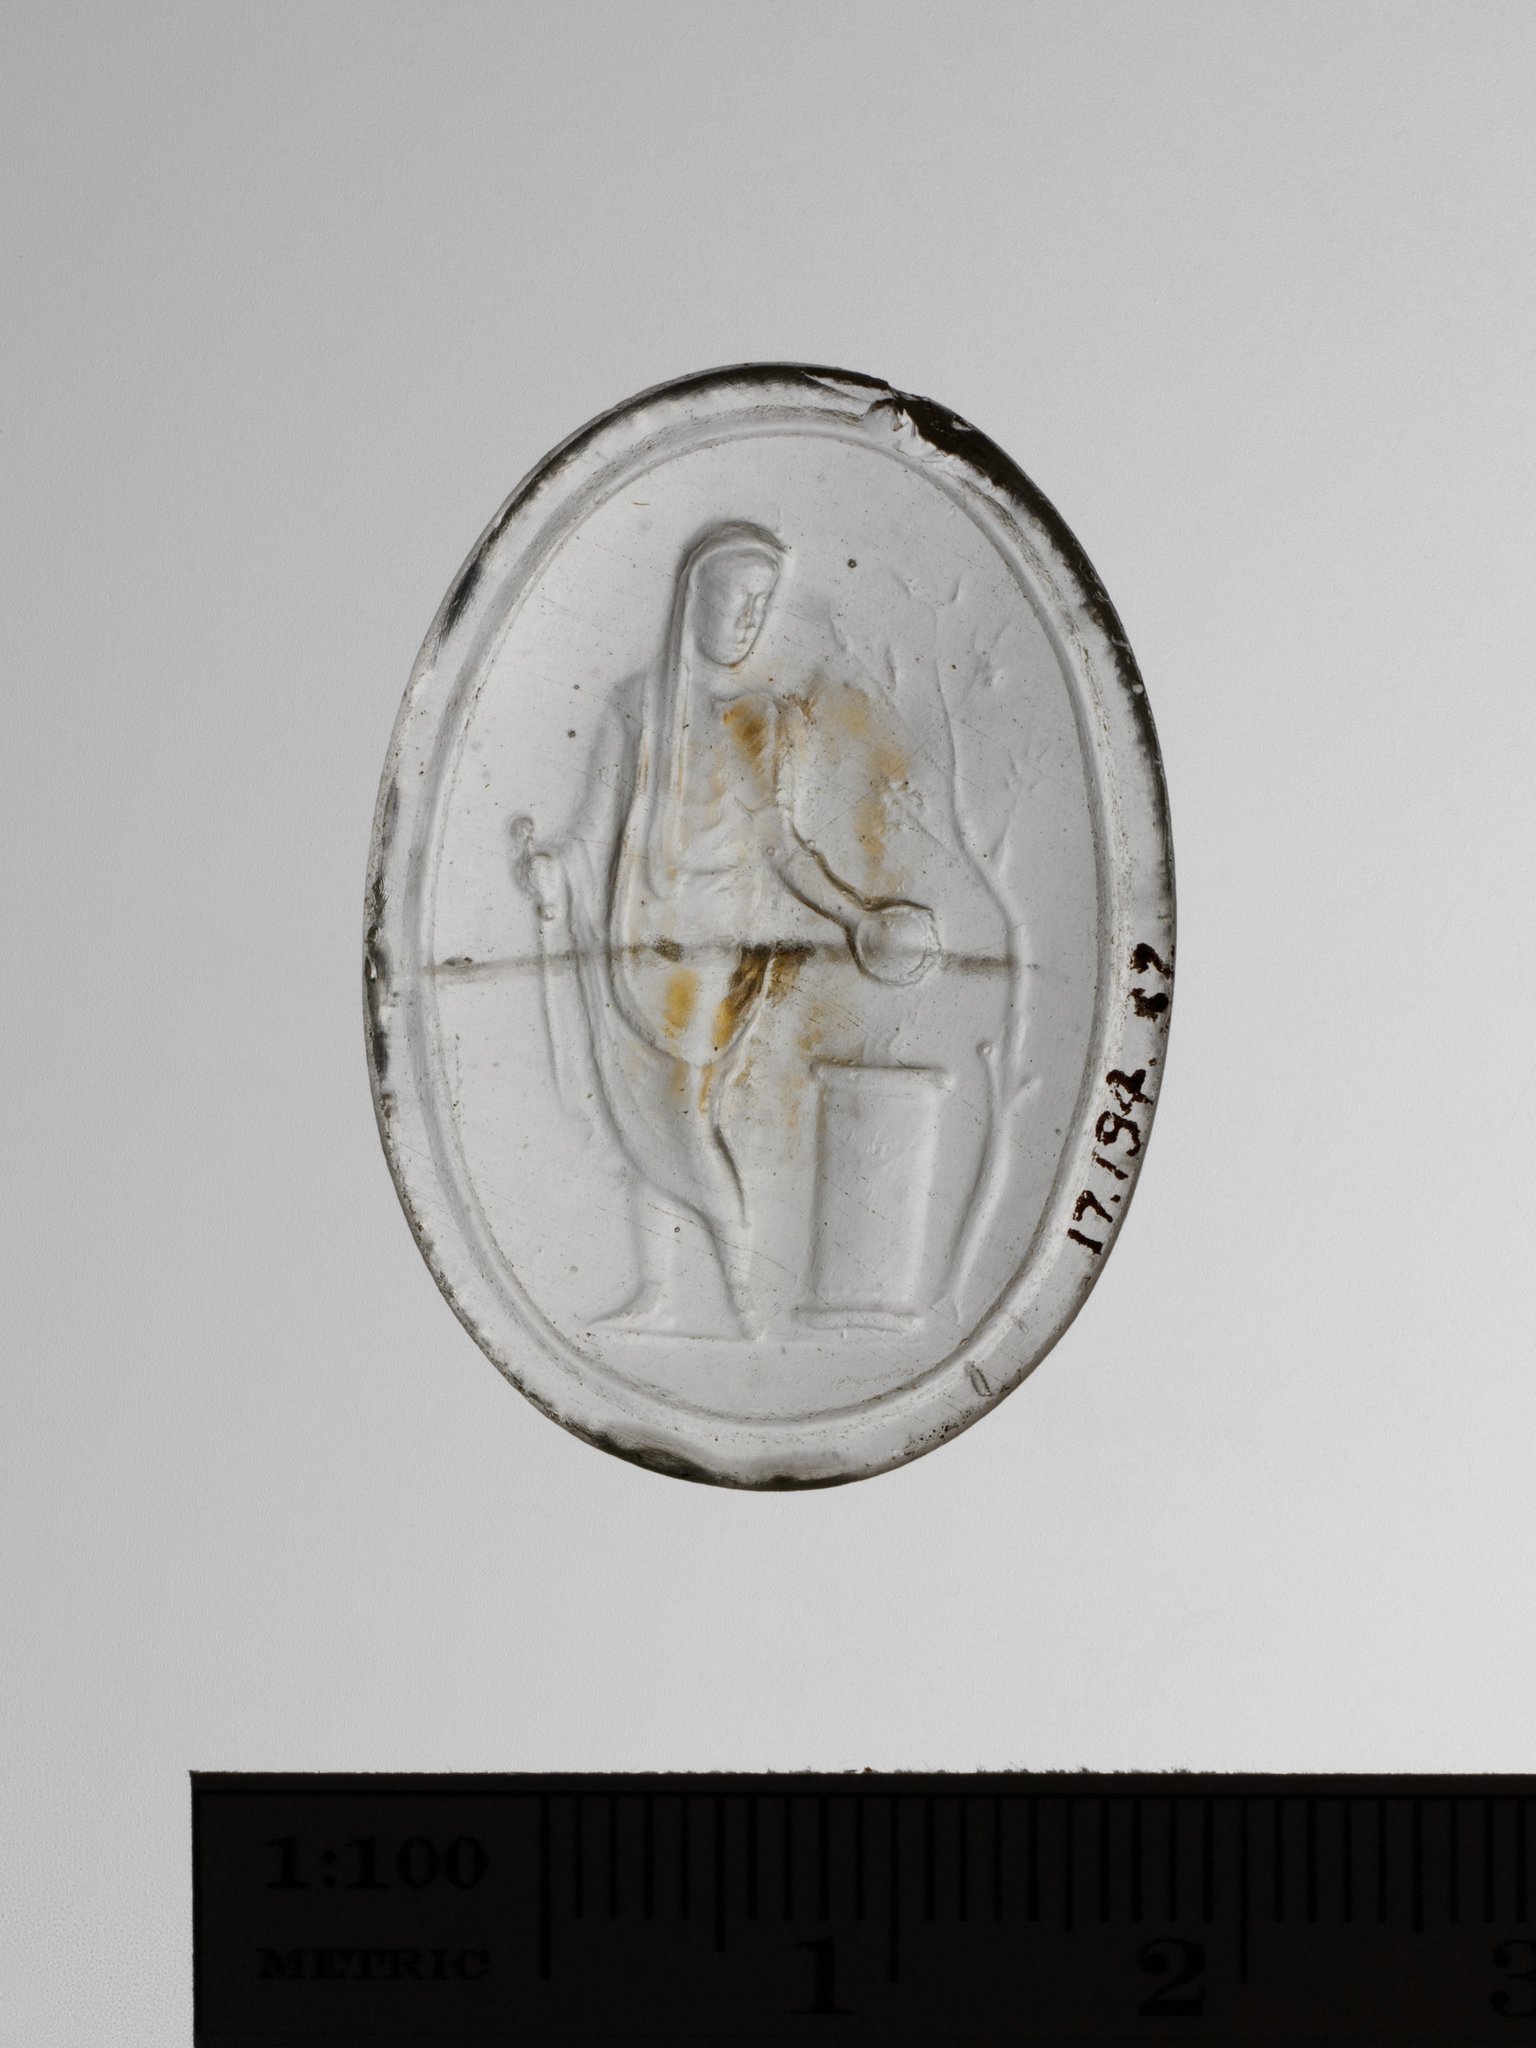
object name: intaglio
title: Colorless glass ring stone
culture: roman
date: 1-100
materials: glass, paste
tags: men